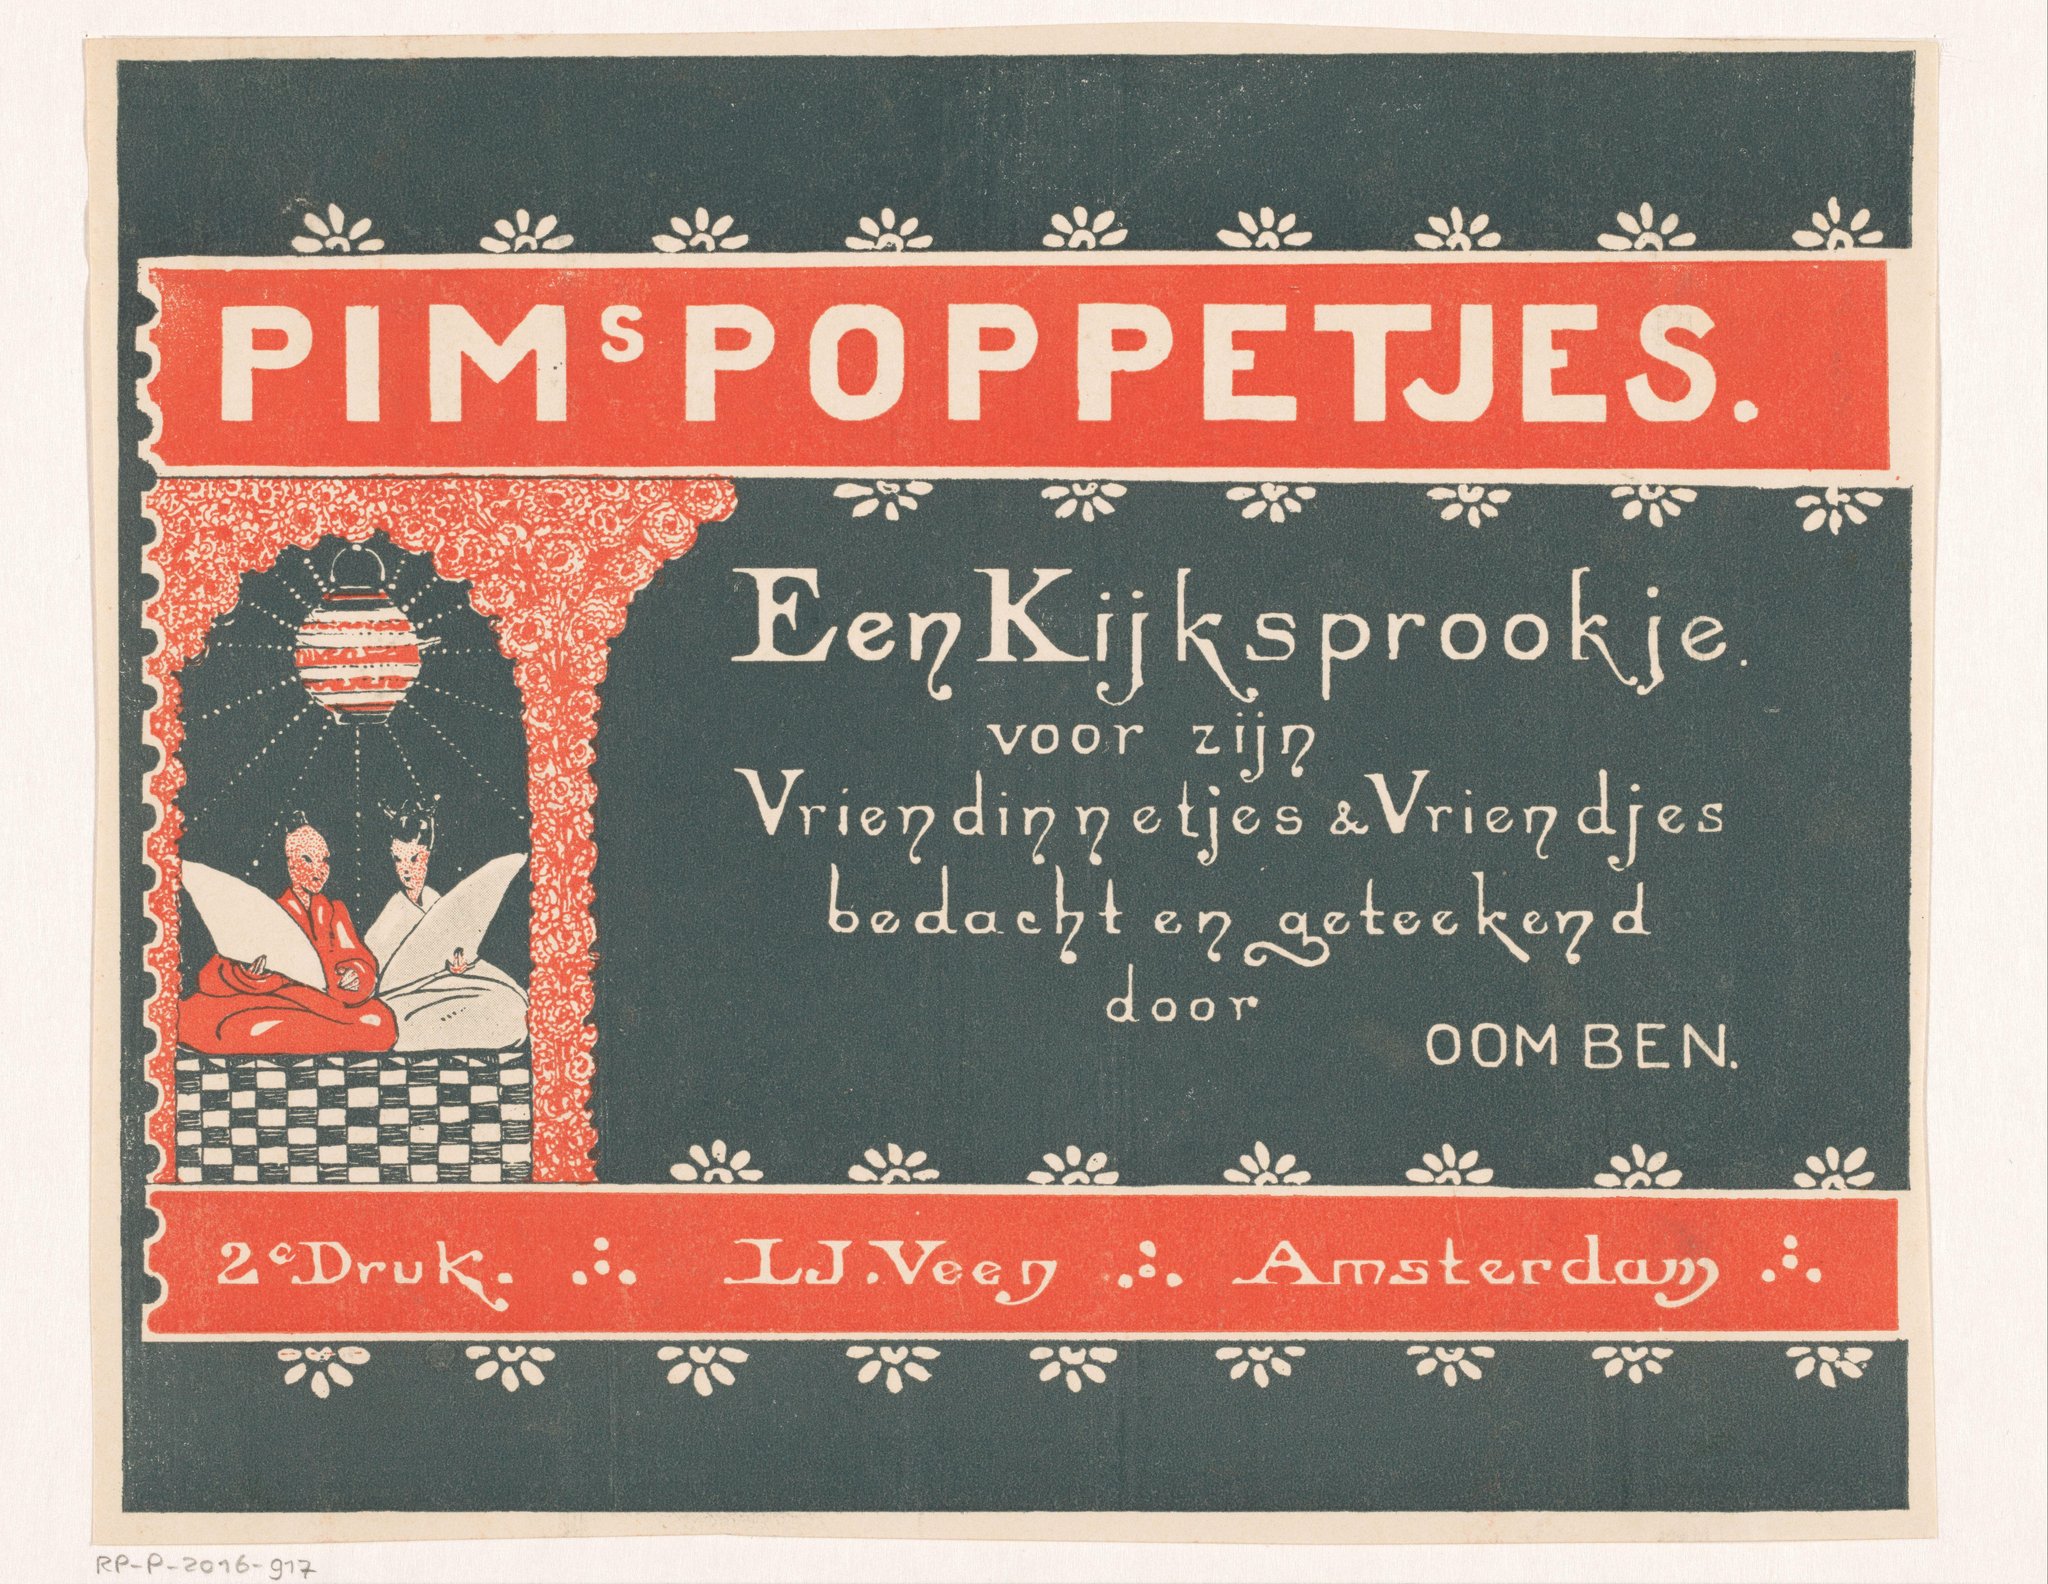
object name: study for binding design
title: Bandontwerp voor: Oom Ben, Pim's Poppetjes: een kijksprookje voor zijn vriendinnetjes en vriendjes, 1913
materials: paper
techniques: lithograph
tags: fan, (playing with) dolls, japanese, flowers ~ ornament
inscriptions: collector's mark: Lugt 2228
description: Een man en vrouw in Japans kostuum, twee van de 'poppetjes' die in de boektitel worden genoemd, zitten op een tegelvloer onder het licht van een lampion in een nis. Ze hebben elk een waaier in de hand. Boven en onder de voorstelling een band versierd met een bloemmotief.